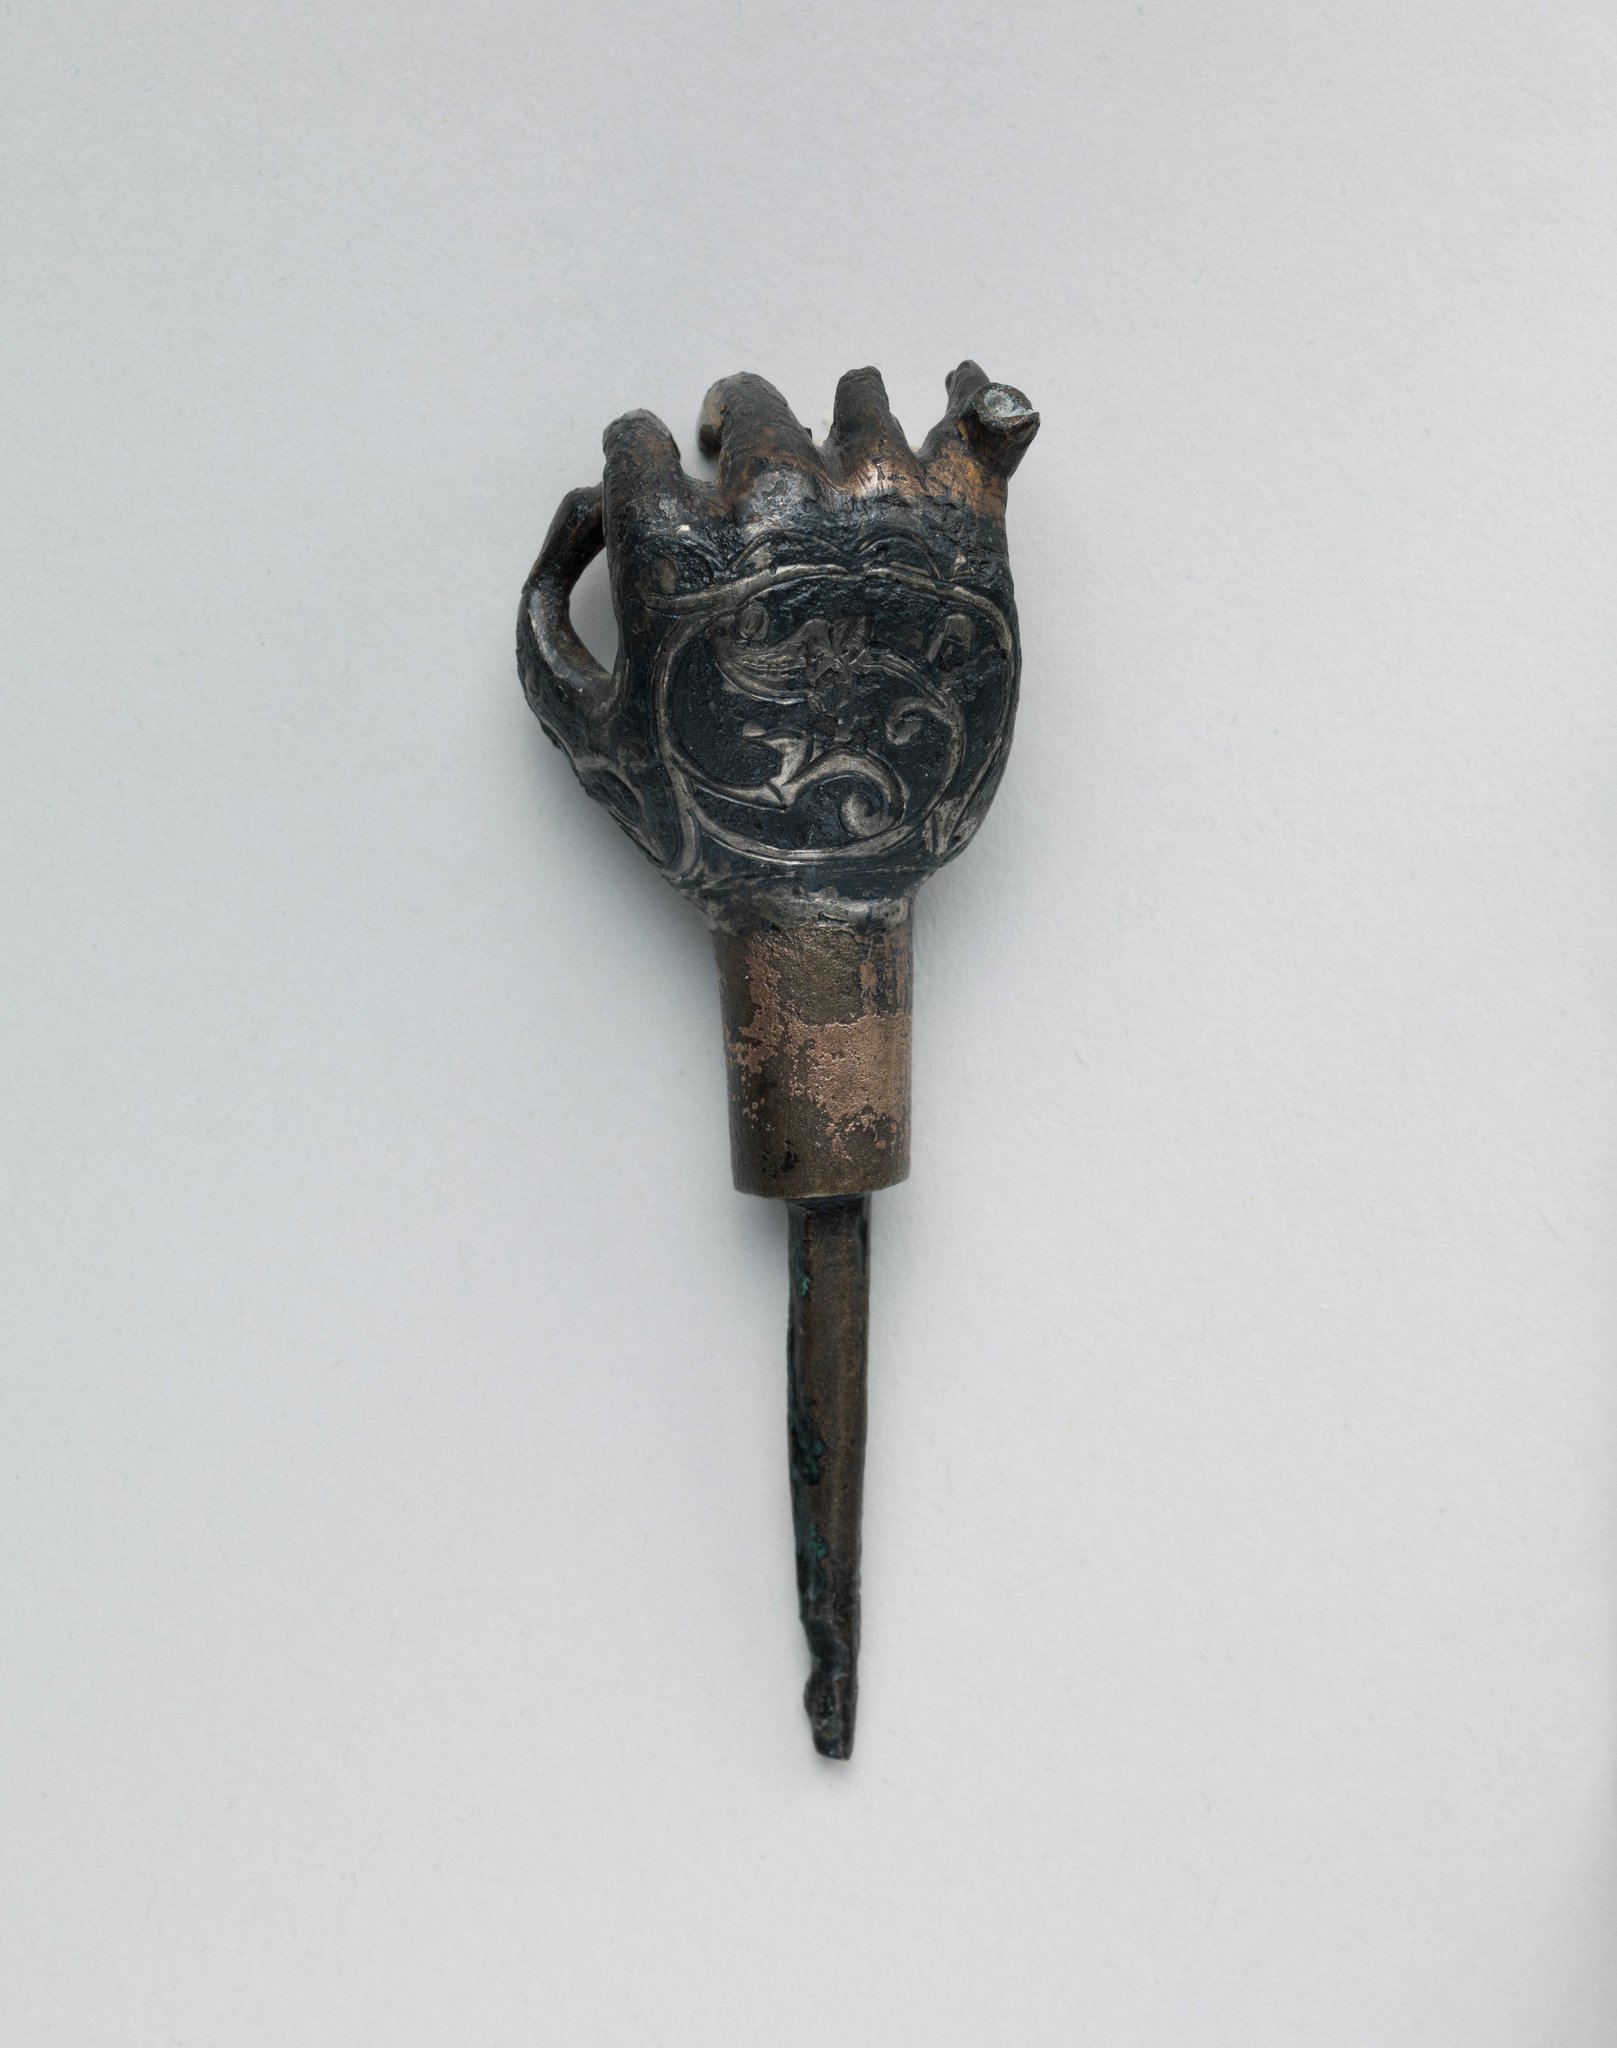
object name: fragment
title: Hand with Niello Decoration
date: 1001-1200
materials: bronze, niello, silver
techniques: gilding, inlay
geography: iran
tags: hands